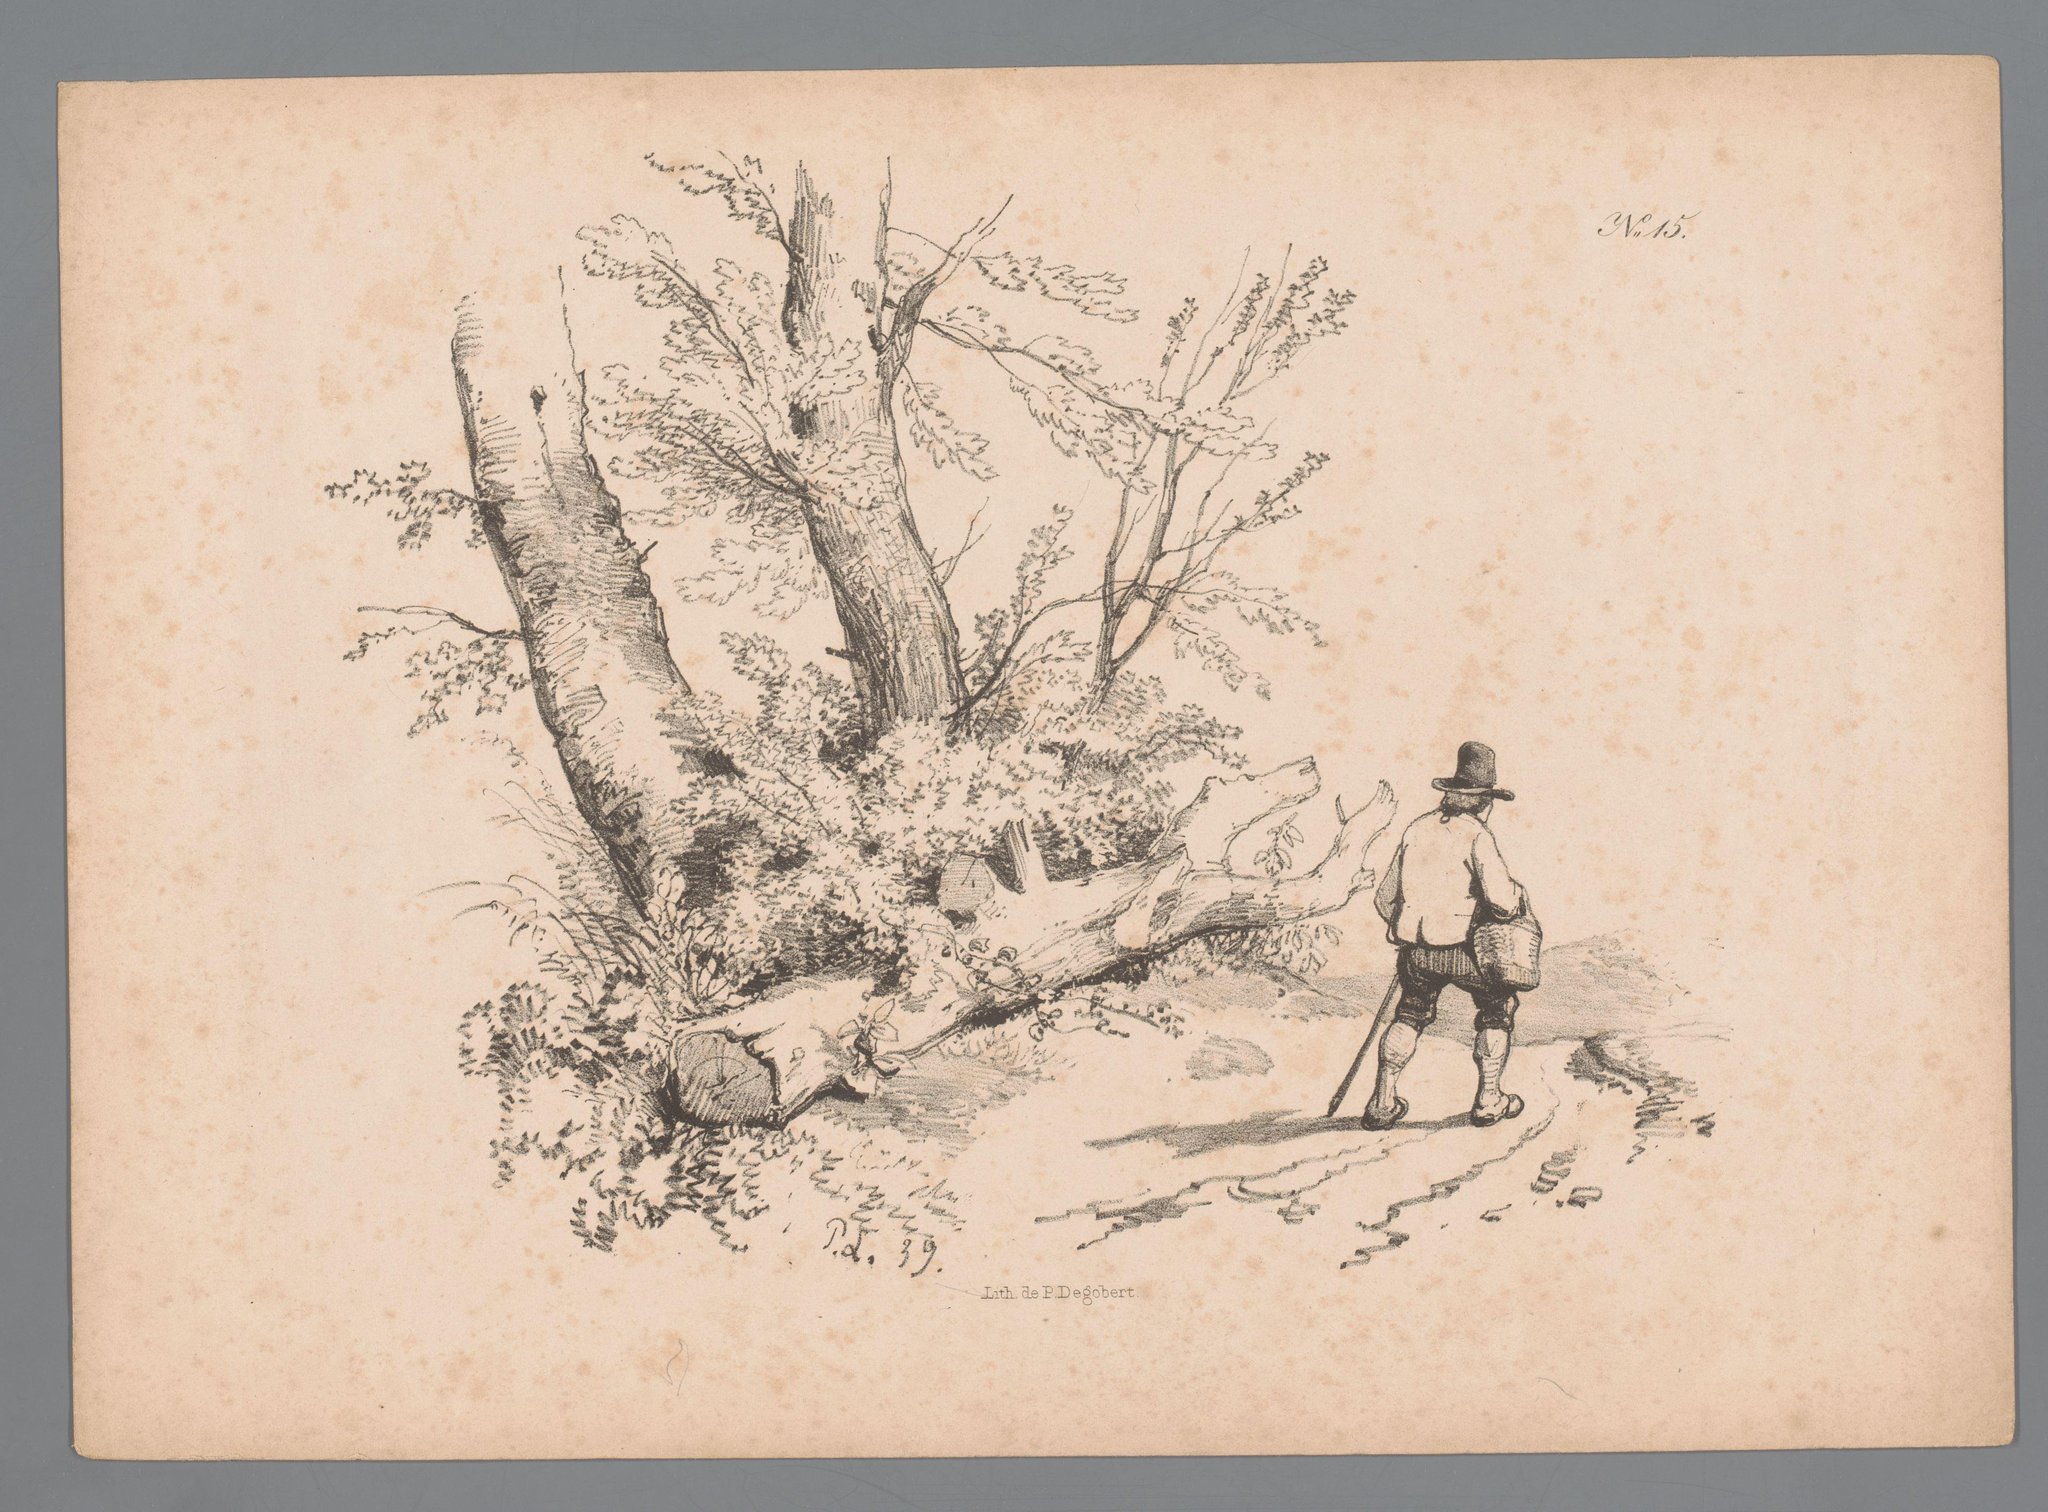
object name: print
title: Landschapsstudies door Paulus Lauters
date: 1839-1840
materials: paper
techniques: lithograph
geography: paris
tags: trees, walking-stick, staff, carrying something in basket, bag, rucksack, etc., landscapes (+ landscape with figures, staffage)